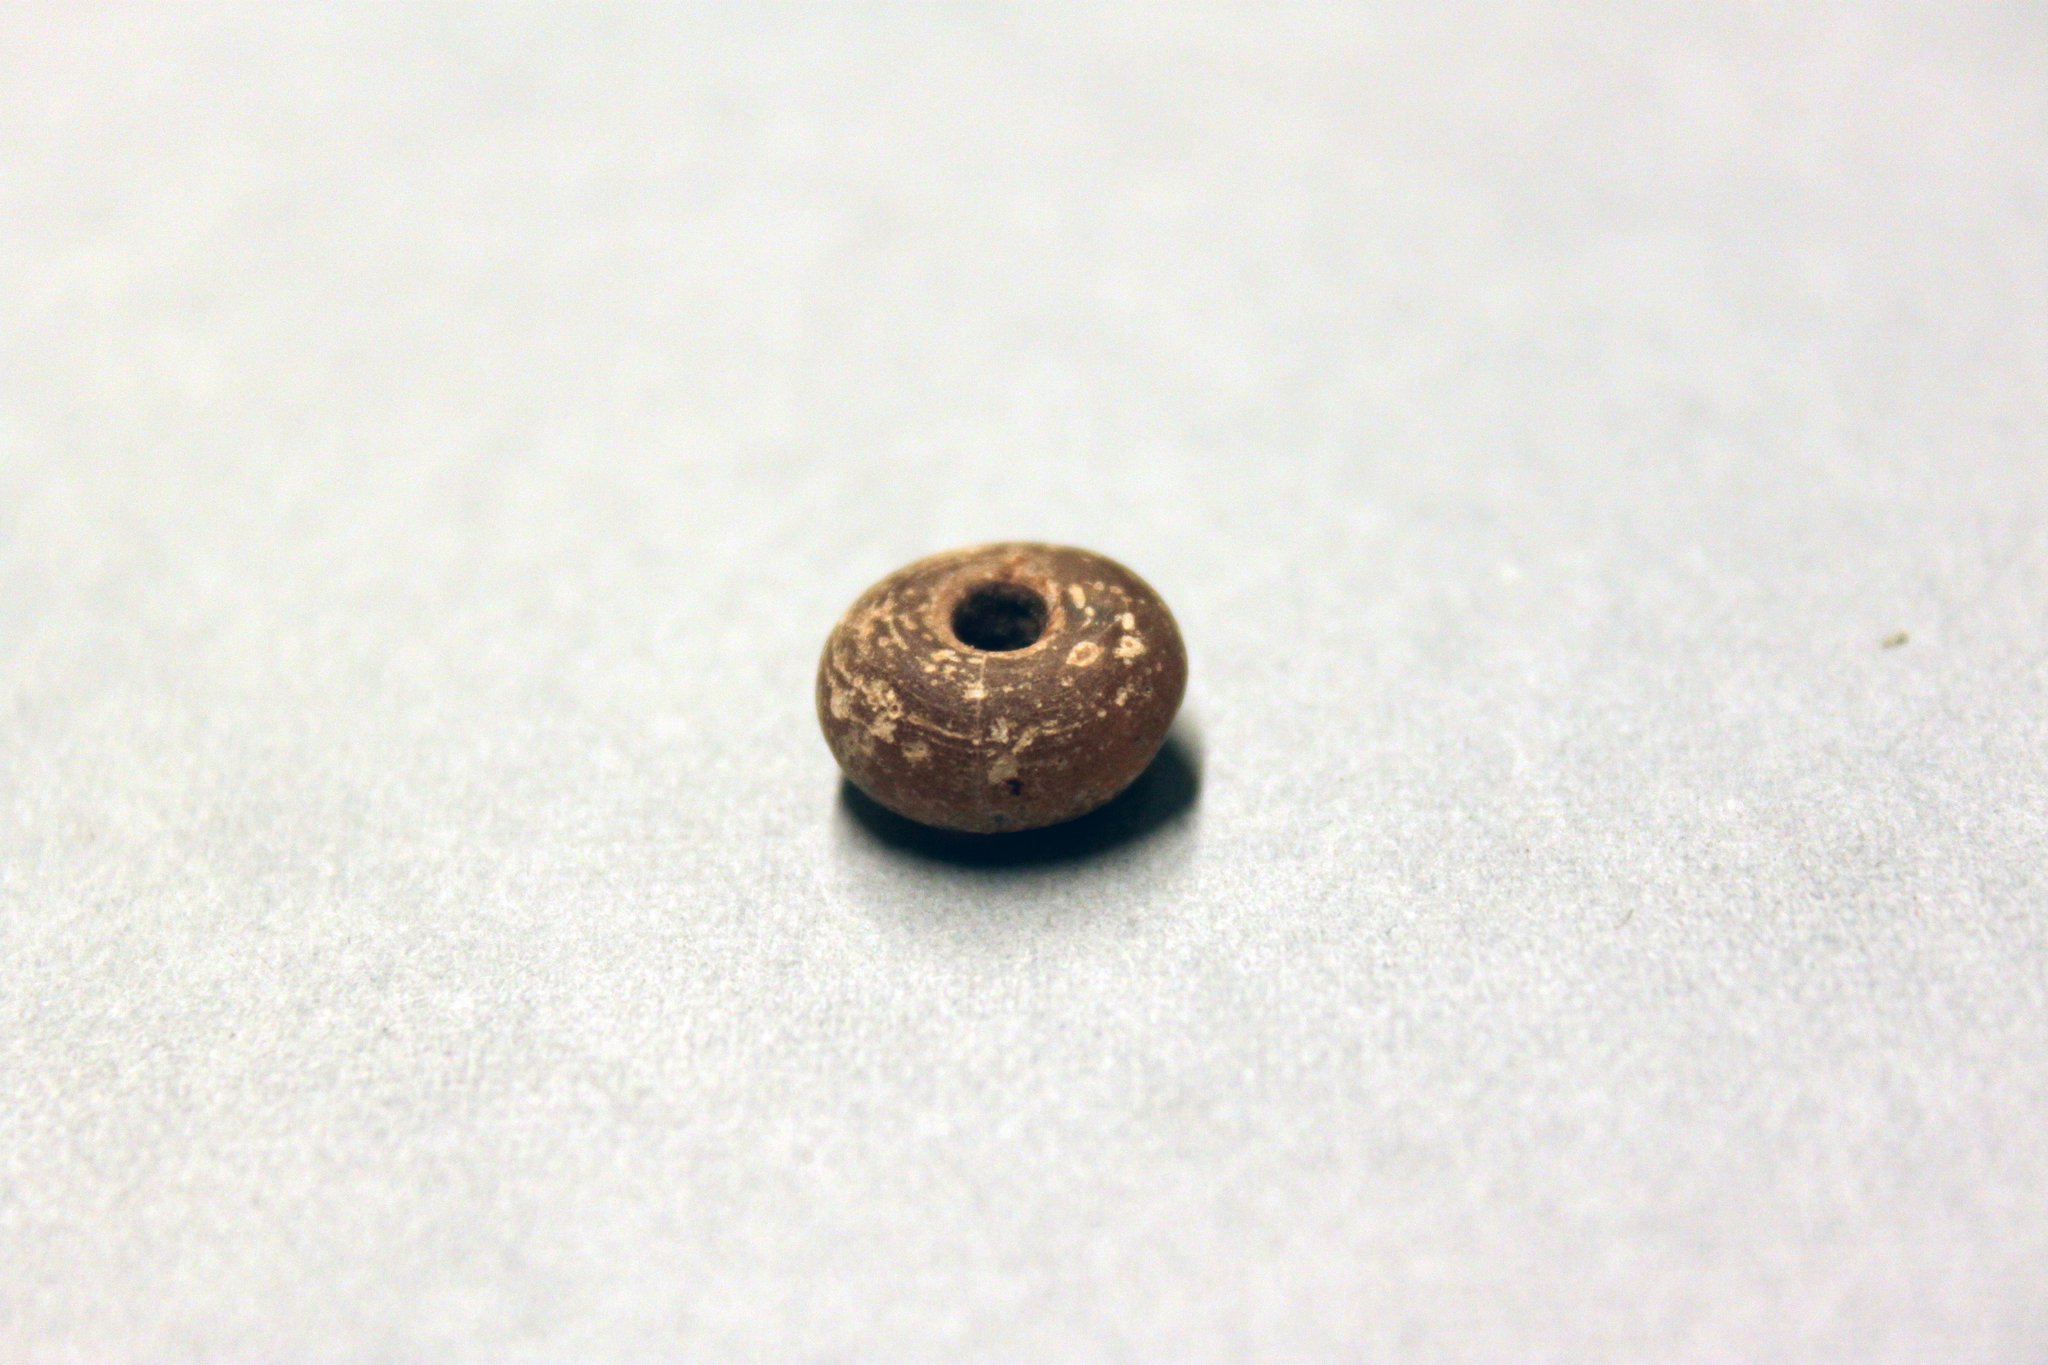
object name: bead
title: Beads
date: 701-1300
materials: glass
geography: iran